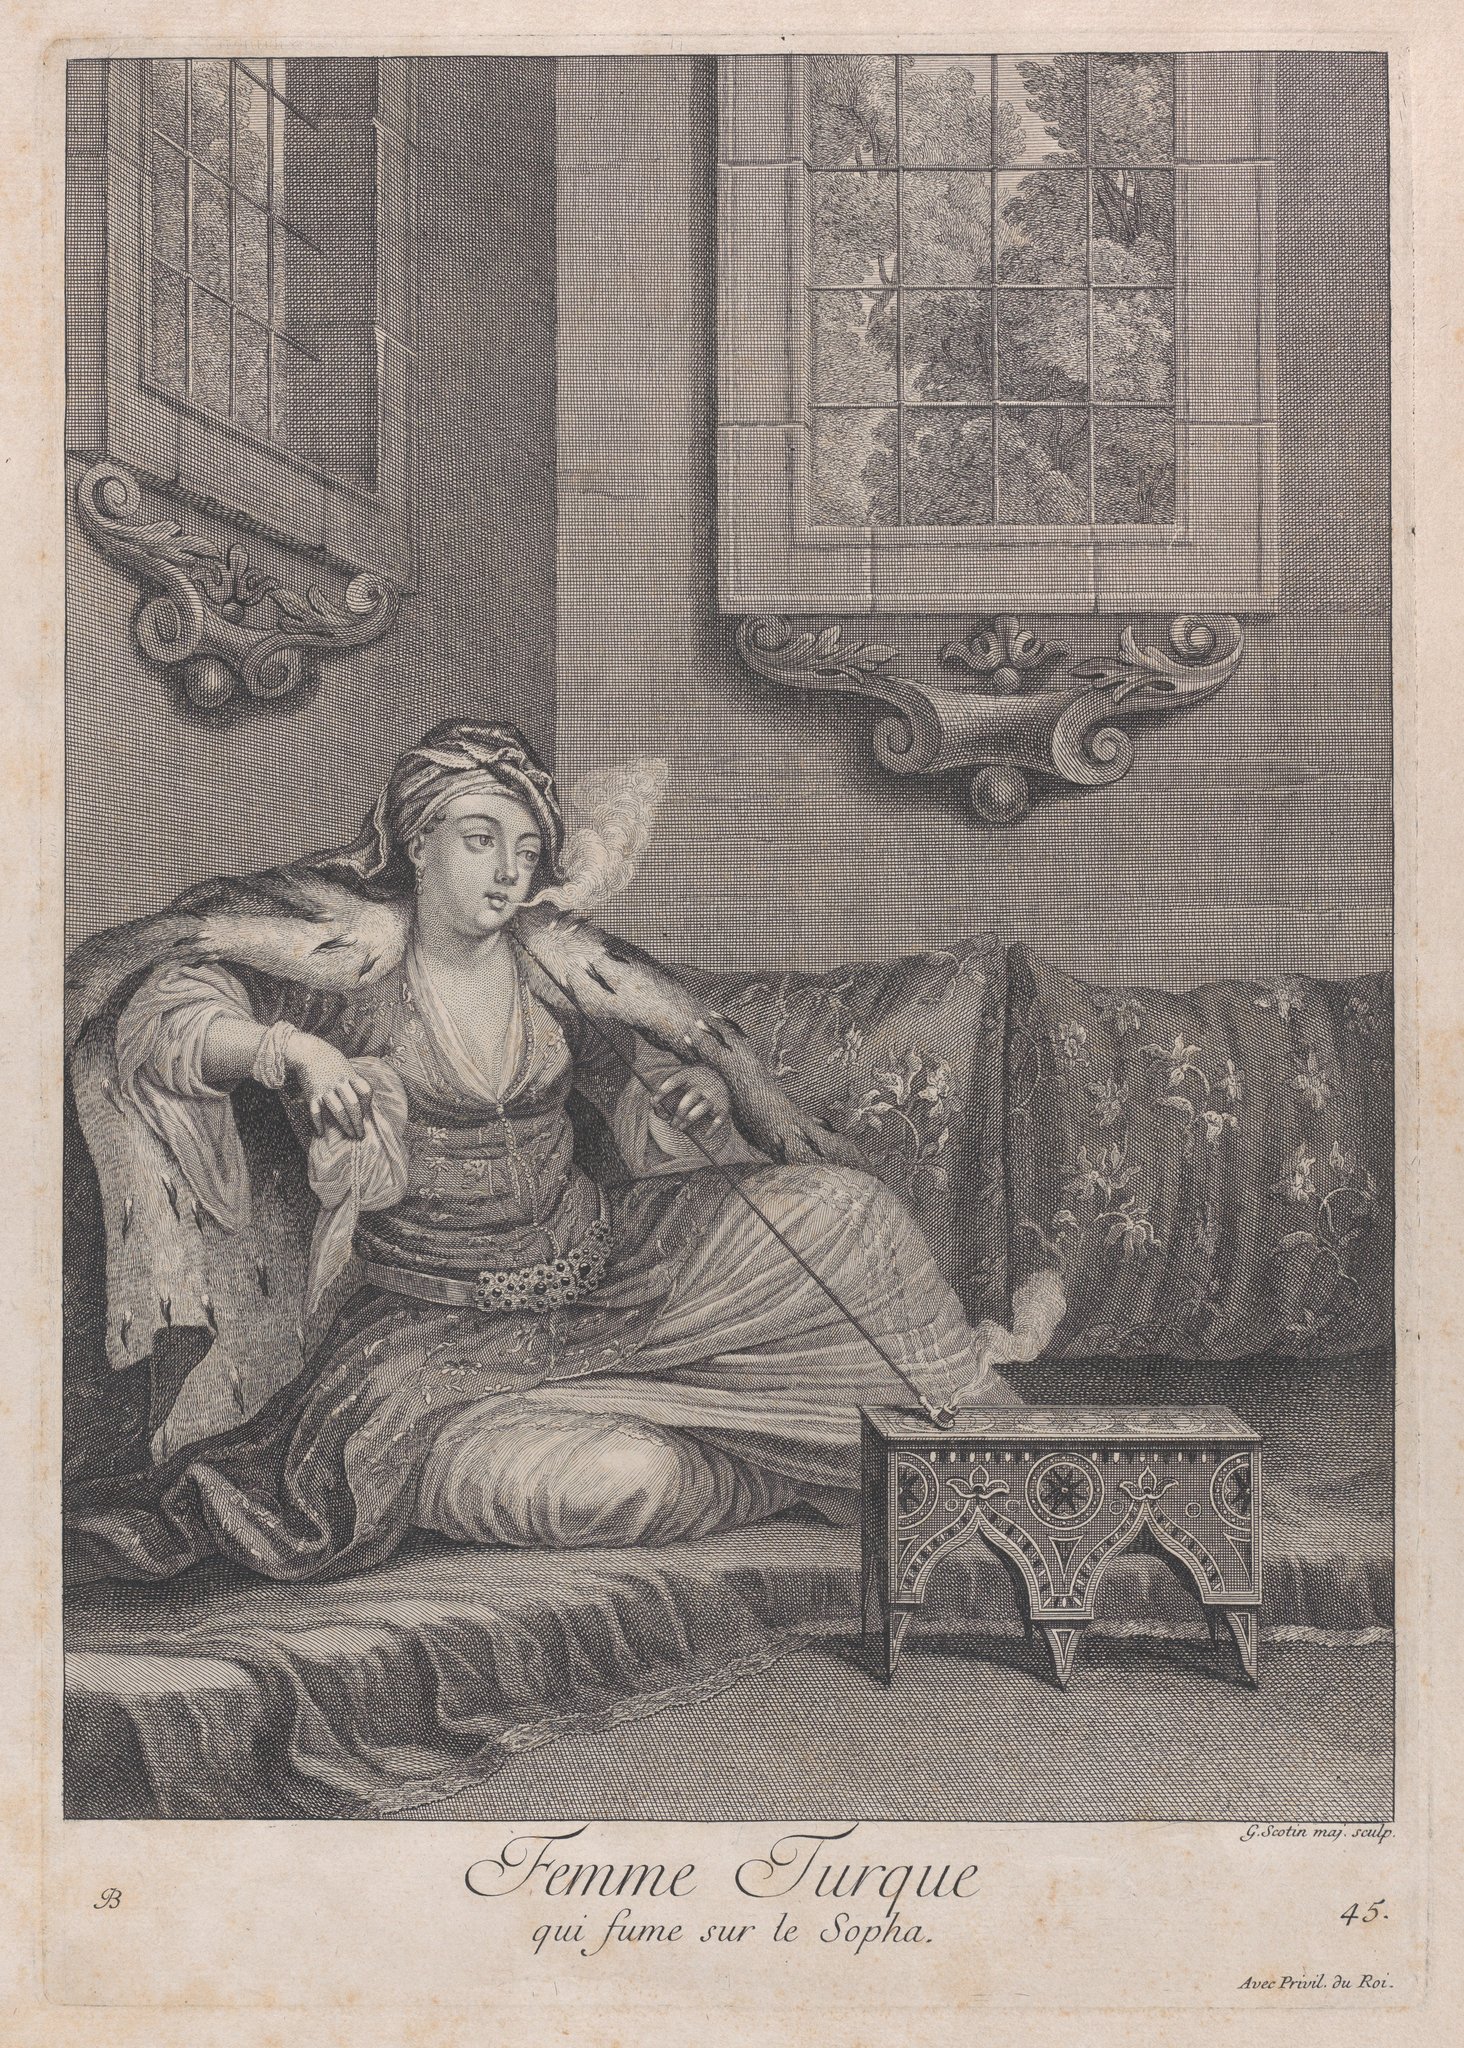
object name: print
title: Femme Turque, qui fume sur le Sopha, plate 45 from "Recueil de cent estampes représentent differentes nations du Levant"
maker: jean baptiste vanmour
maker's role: artist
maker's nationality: french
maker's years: 1671-1737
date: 1714-1715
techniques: engraving, etching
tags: women,smoking,pipes